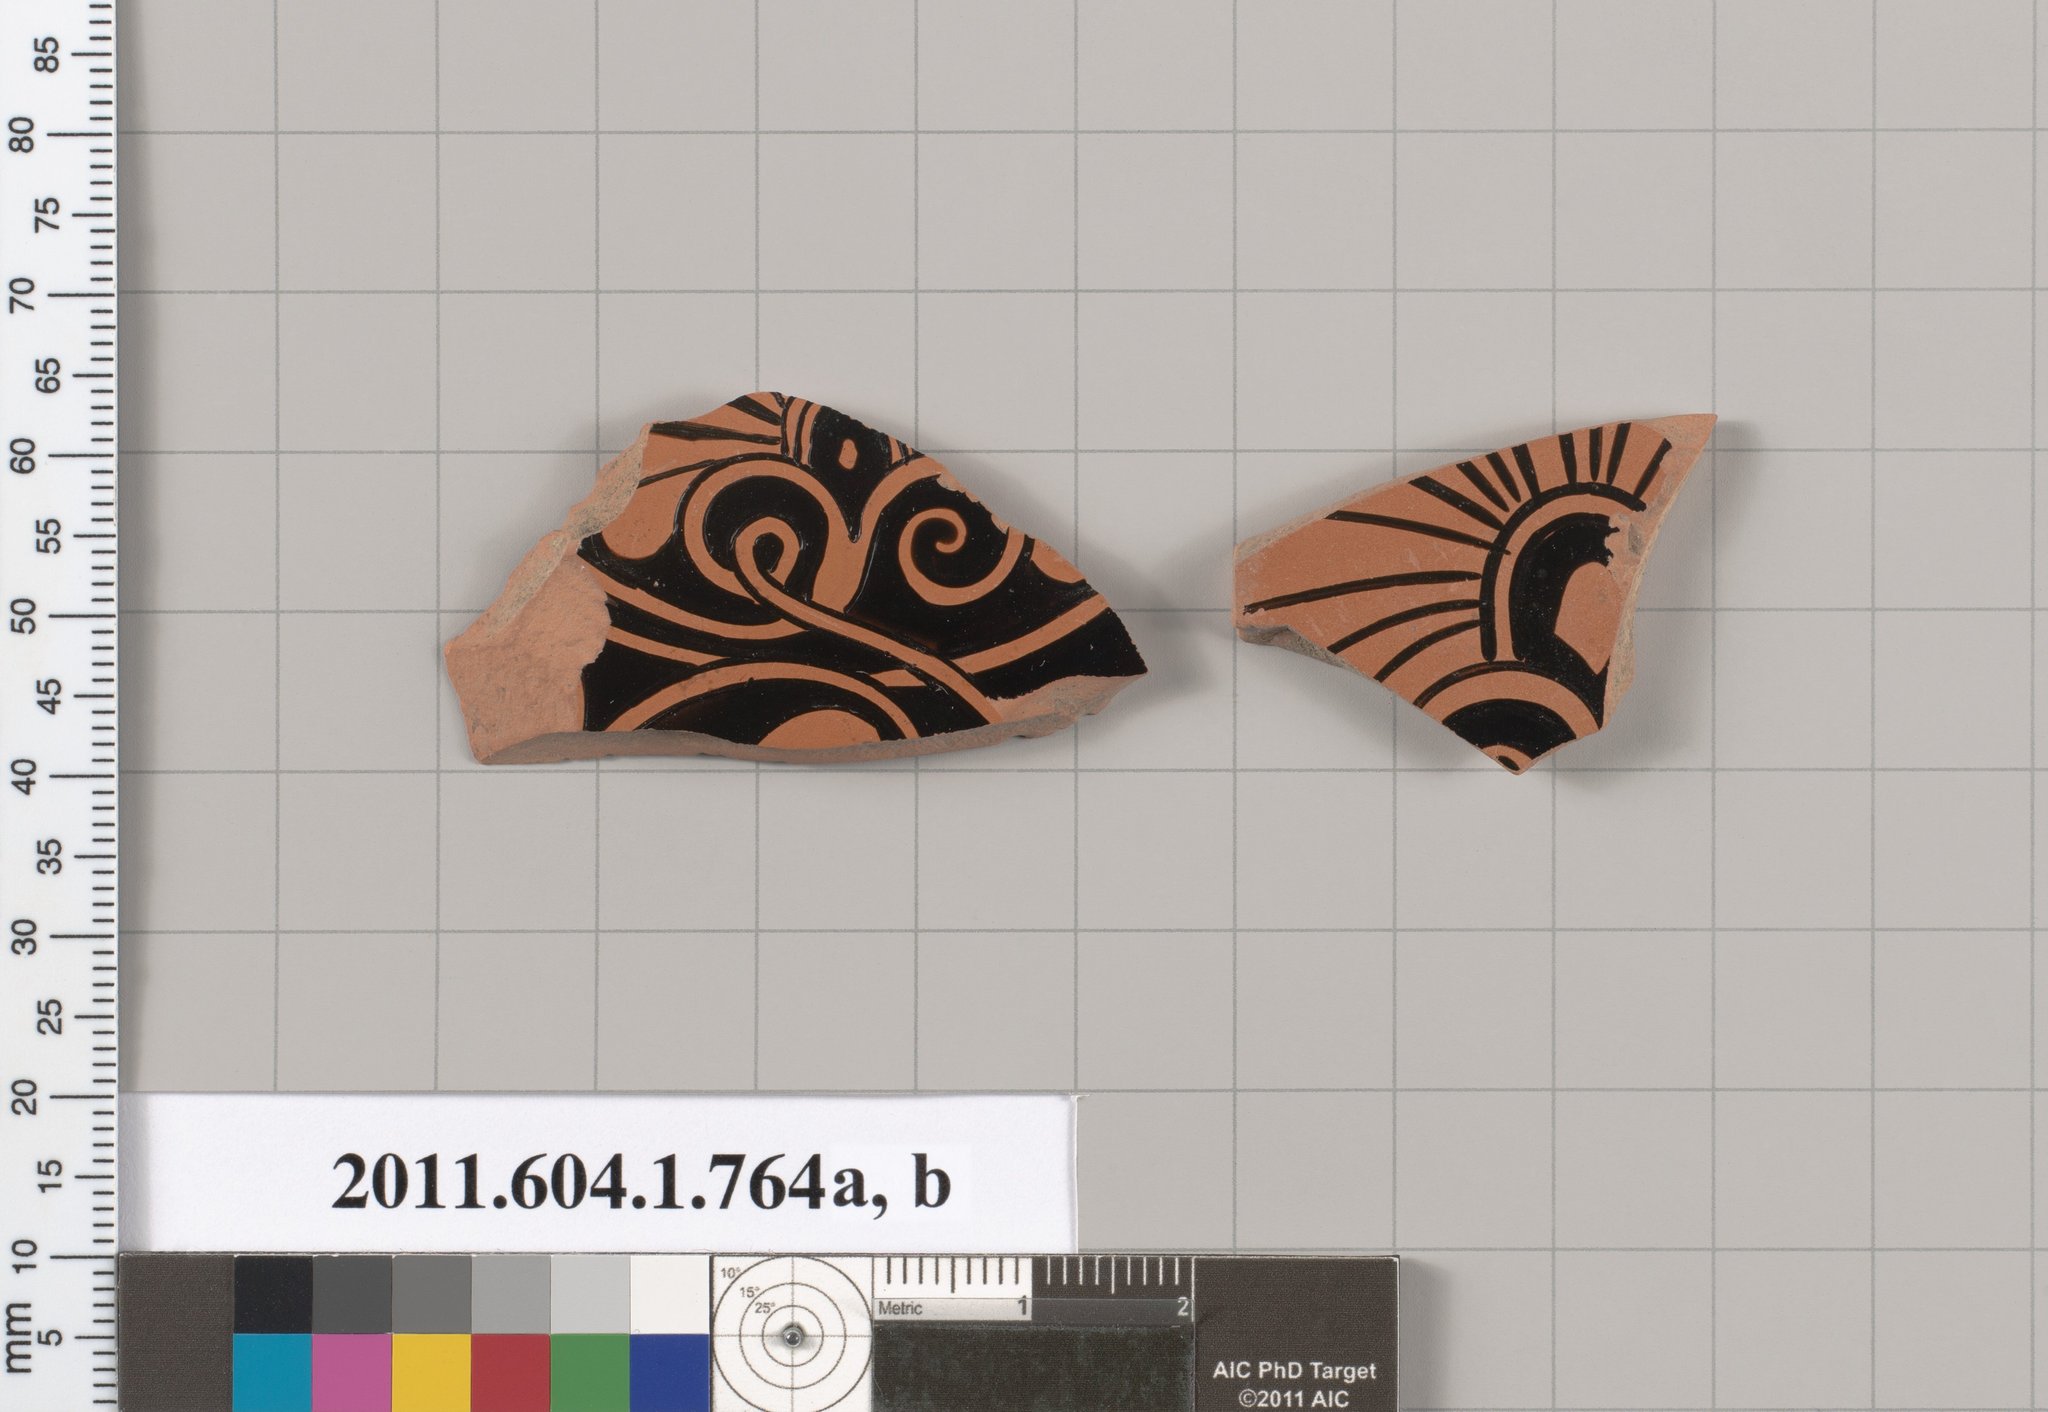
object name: kylix fragment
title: Terracotta fragments of kylikes (drinking cups)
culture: greek, attic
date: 520-490 BCE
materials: terracotta